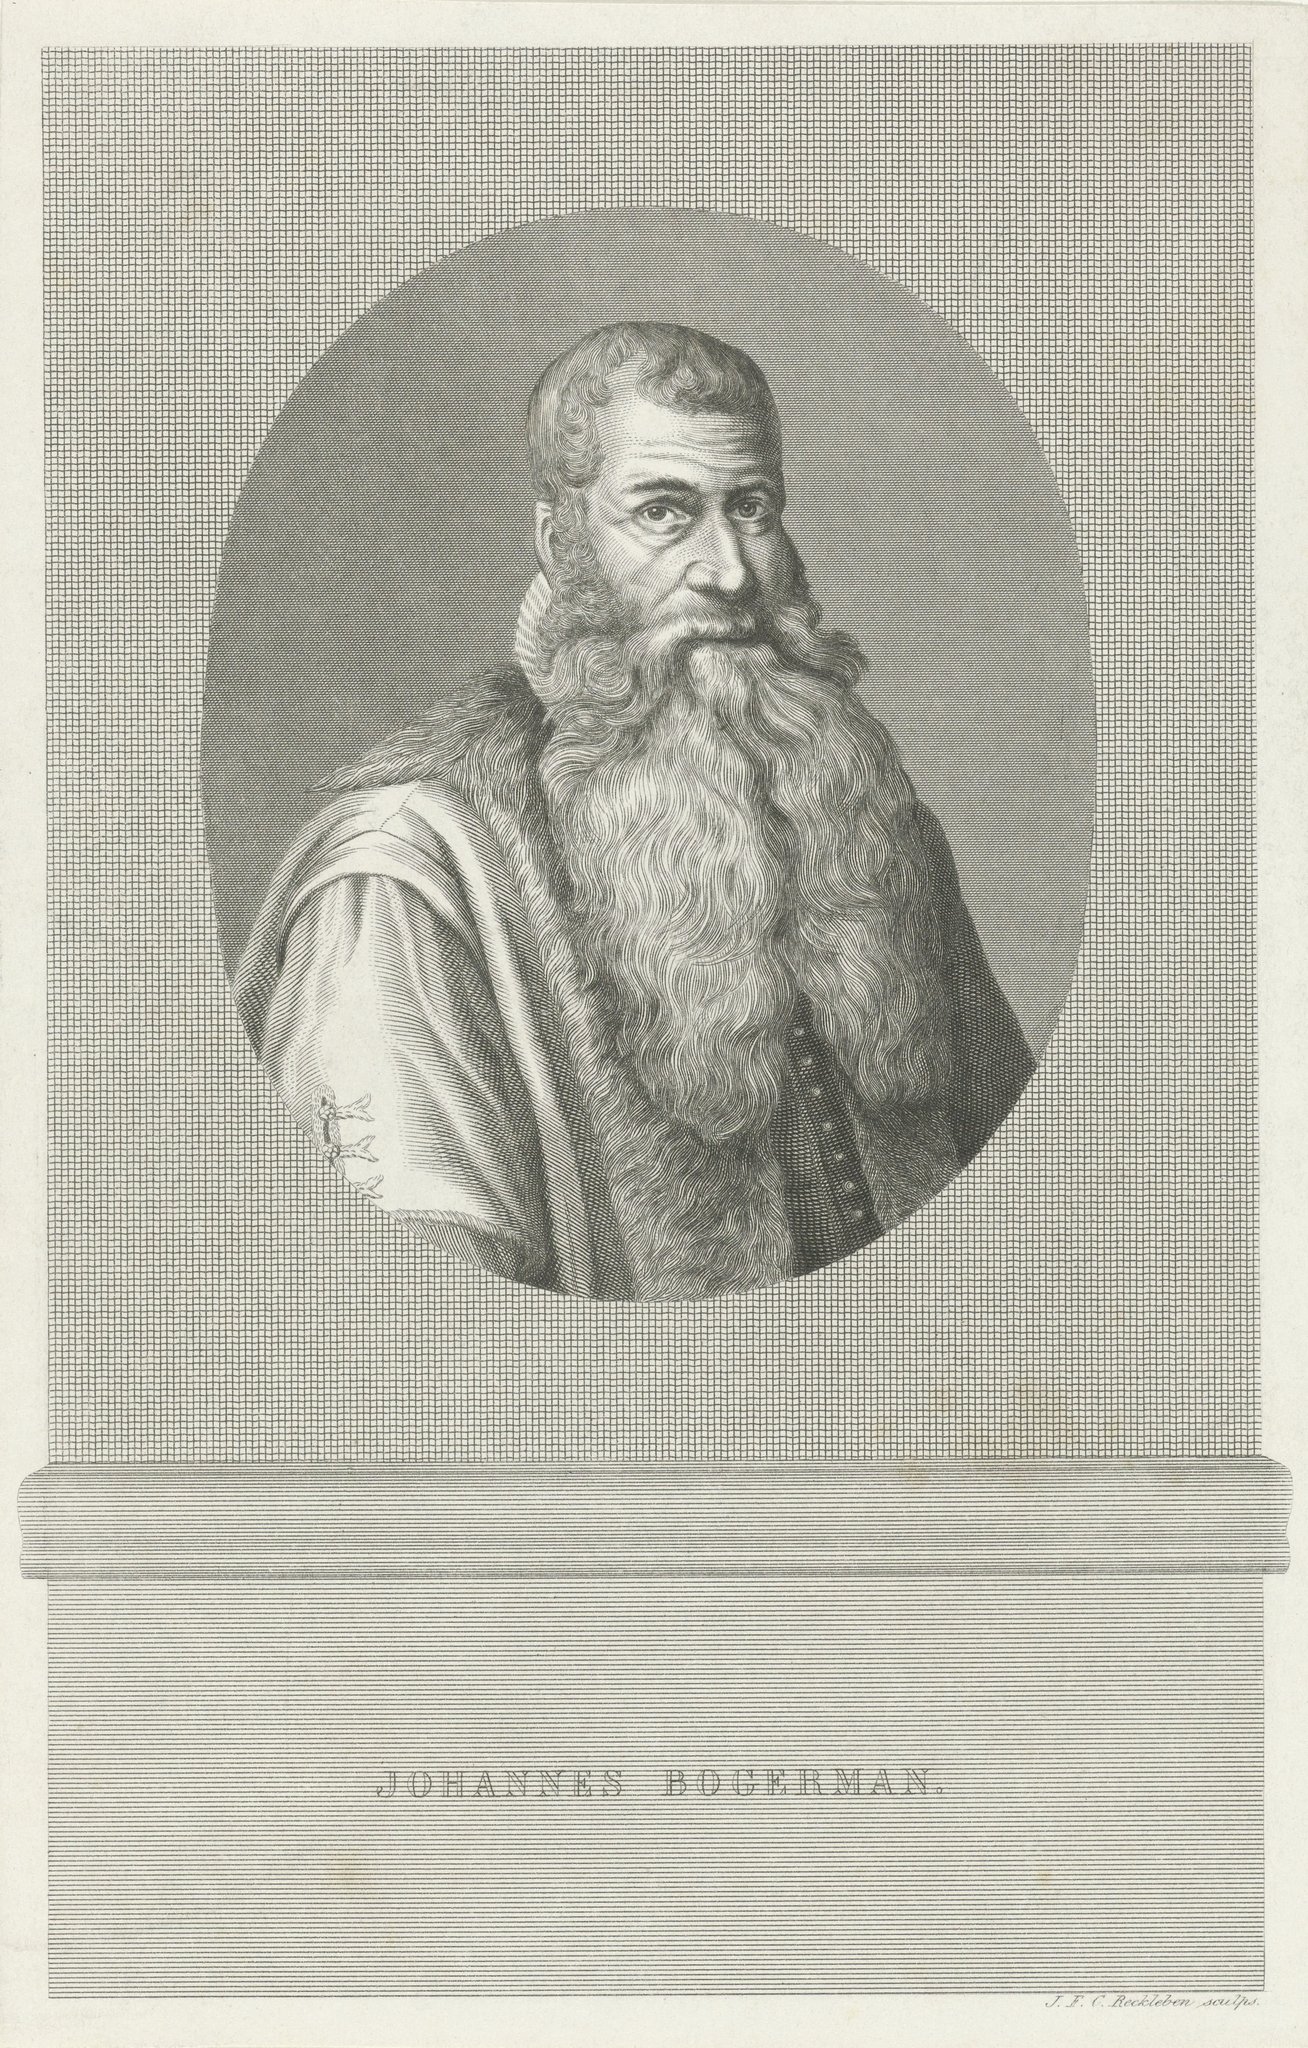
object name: print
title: Portret van Johannes Bogerman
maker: jan frederik christiaan reckleben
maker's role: print maker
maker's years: 1819-1879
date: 1855-1857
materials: paper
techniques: engraving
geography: amsterdam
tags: johannes bogerman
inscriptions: collector's mark: Lugt 2228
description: Illustratie in: Arend, Johannes Pieter. Algemeene geschiedenis des vaderlands van de vroegste tijden tot op heden. 5 delen, Amsterdam: Schleijer, J.F. 1840-1884, dl. 3.2, p. 795.